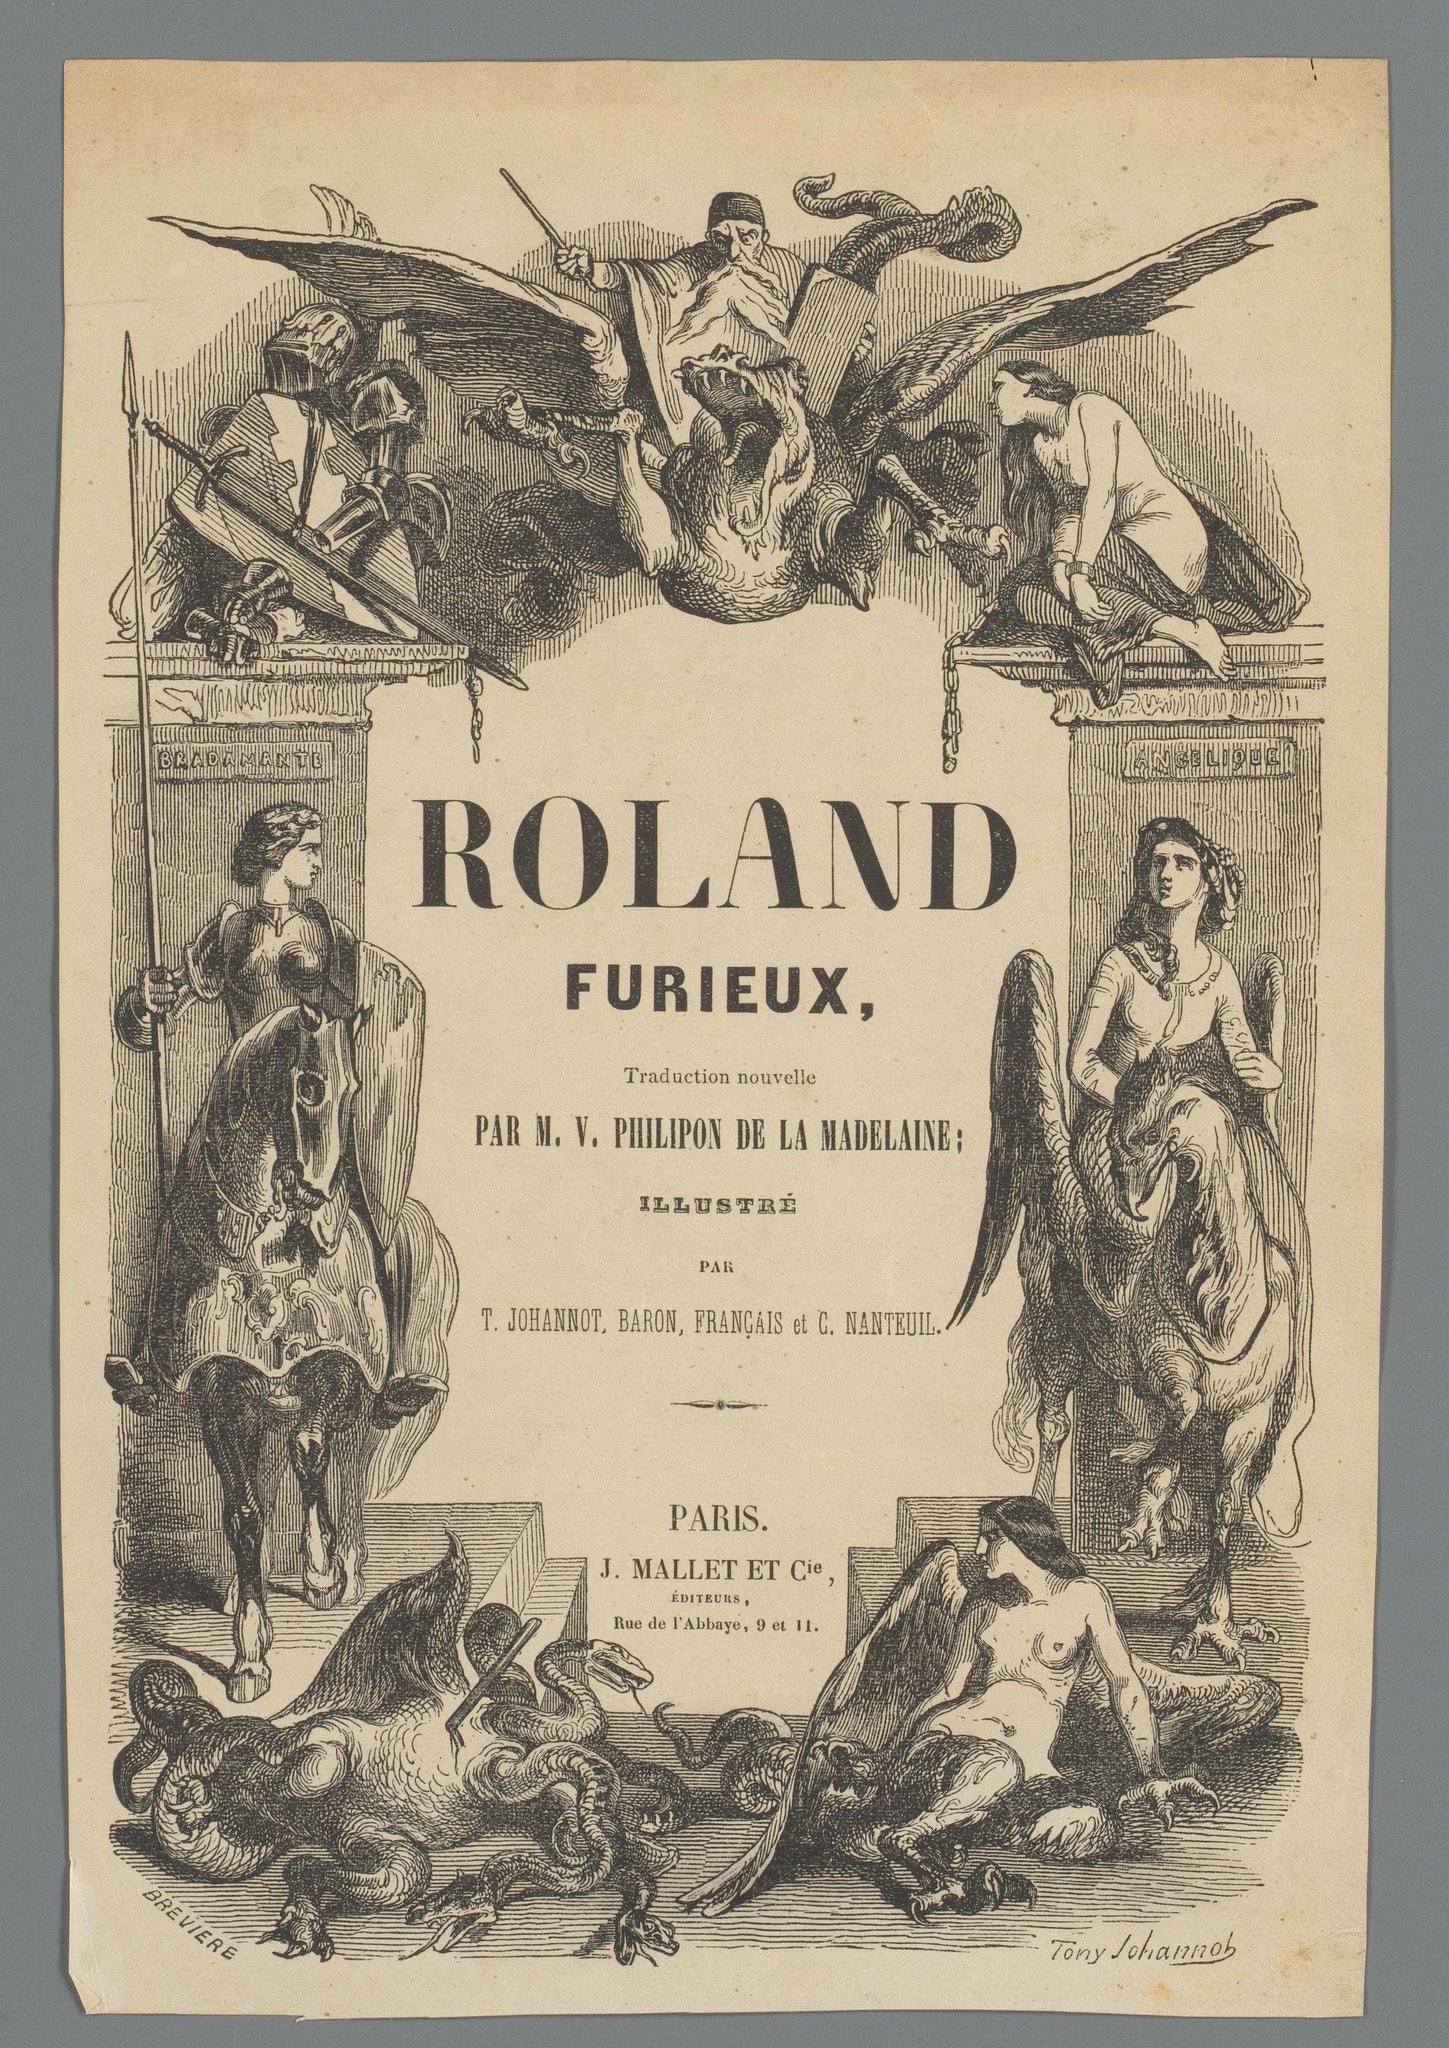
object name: print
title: Roland furieux, traduction nouvelle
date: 1844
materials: paper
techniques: engraving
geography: paris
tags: title-page, (scenes from) specific works of literature: ariosto, orlando furioso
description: Titelpagina uit: Ariosto, Ludovico. Roland furieux, traduction nouvelle par M.V. Philipon de la Madelaine; illustré par T. Johannot, Baron, Français et C. Nanteuil. Parijs: J. Mallet & Co., [1844].